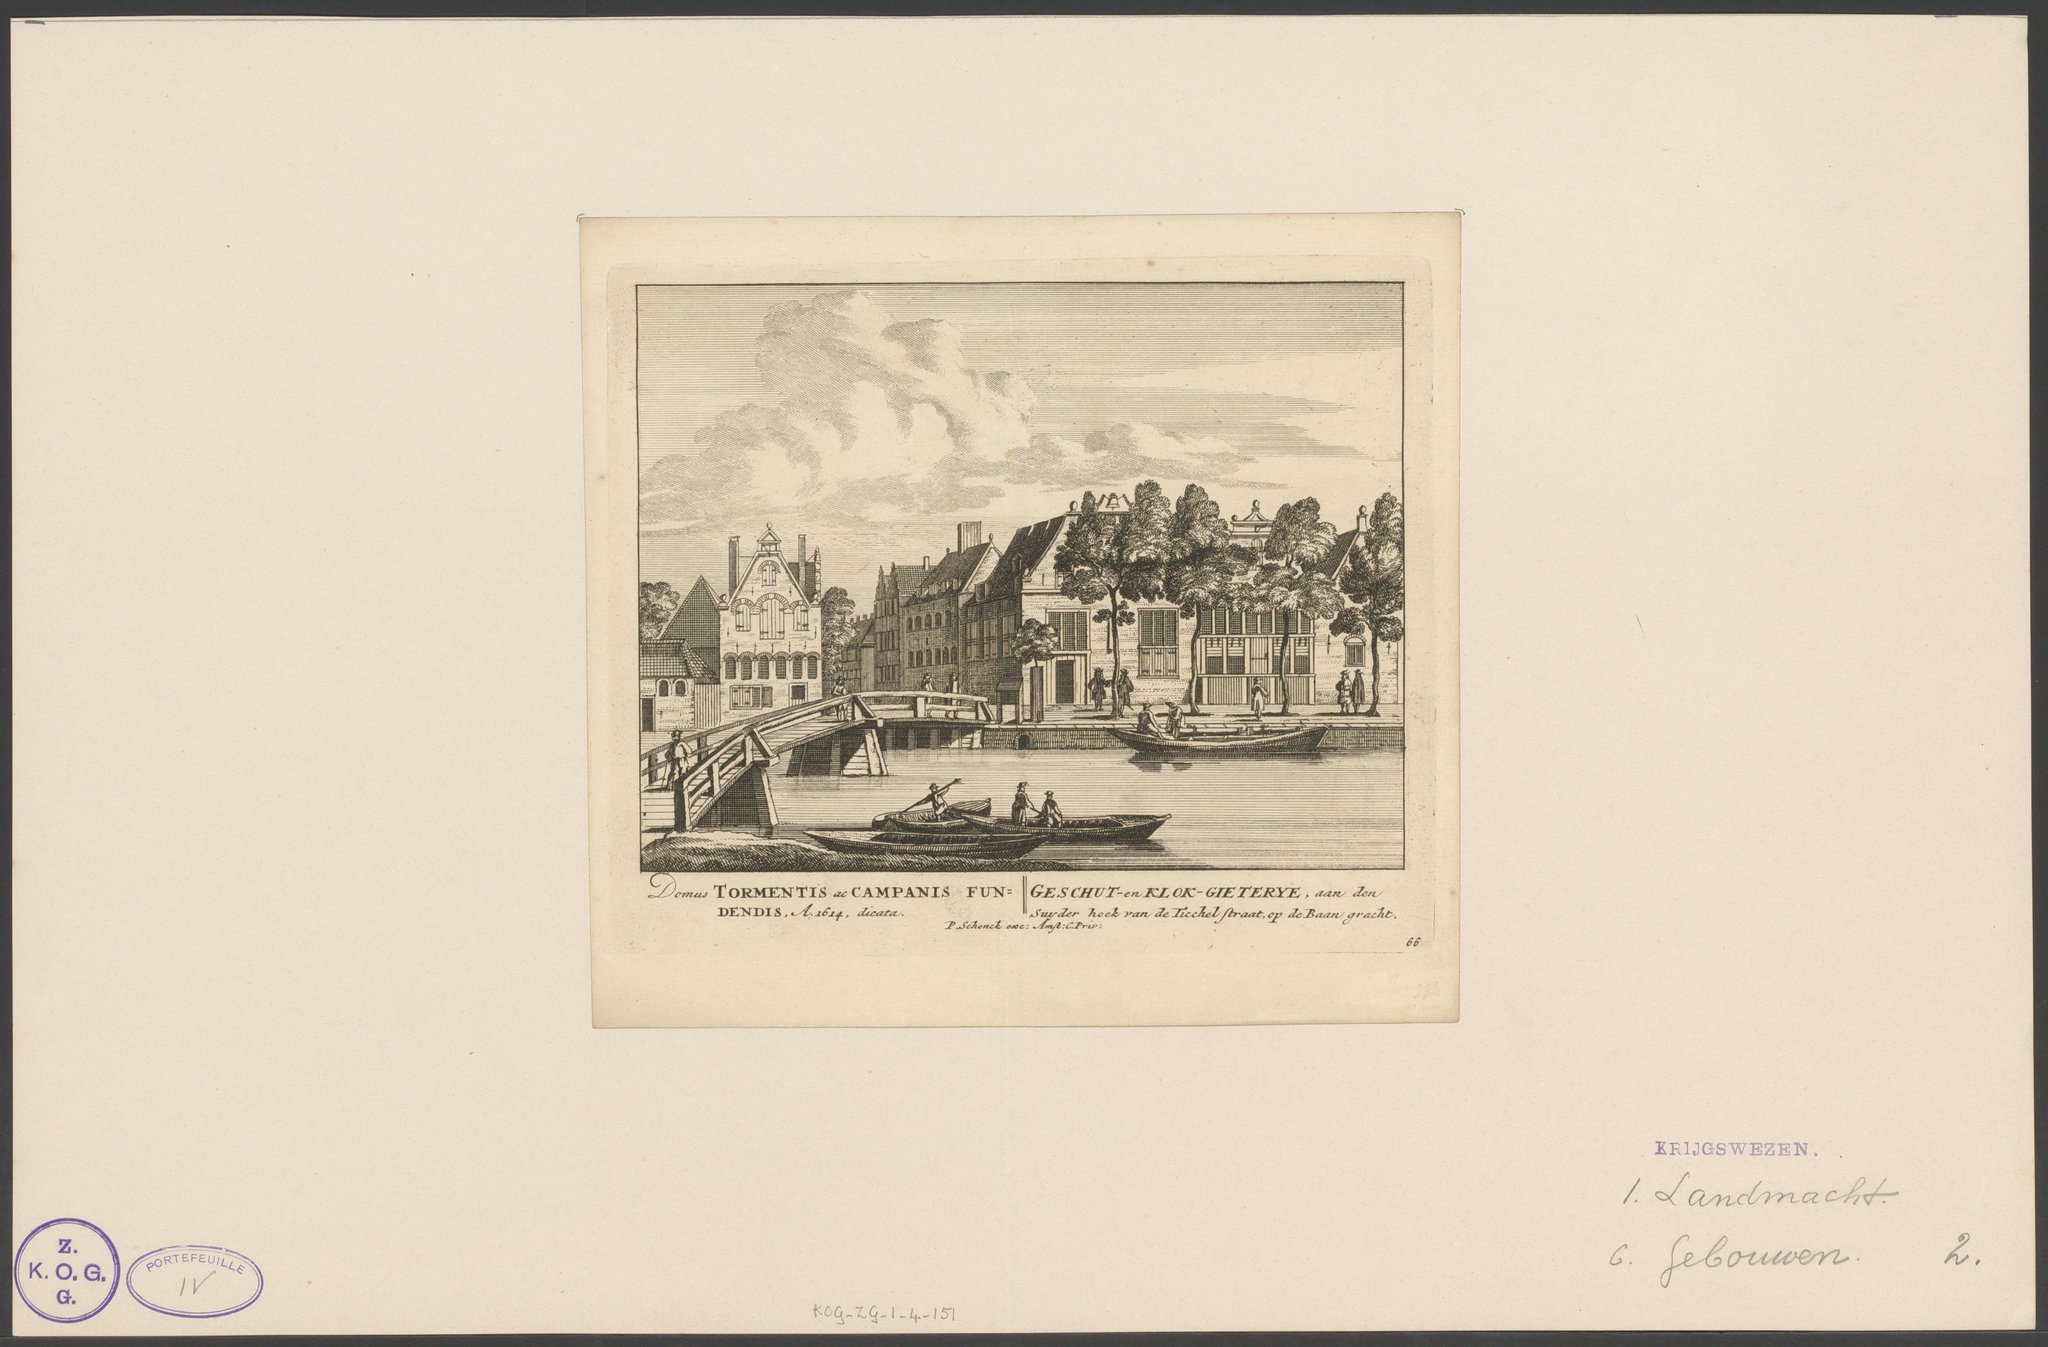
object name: print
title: Geschut- en Klok-Gieterye, aan den suyder hoek van de Ticchel straat, op de Baangracht / Domus Tormentis ac Campanis Fundendis, A. 1614 dicata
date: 1710-1711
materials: paper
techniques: engraving, etching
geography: amsterdam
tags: bell-founder, factory-building, canals, waters (in city) (+ city(-scape) with figures, staffage), street (+ city(-scape) with figures, staffage)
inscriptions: collector's mark: Lugt 1641, collector's mark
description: Genummerde staat van prent gebruikt in: 100 Afbeeldinge der voornaamste gebouwen van Amsterdam. Amsterdam, Pieter Schenk (I), s.a. [1710-1711]. En in: 100 Afbeeldinge der voornaamste gebouwen van Amsterdam. Amsterdam, Barent Greve, s.a. [1757-1766]. In de tweede uitgave, uitgegeven door Barent Greve, is alleen de titelprent aangepast. De overige prenten zijn onveranderd gebleven.